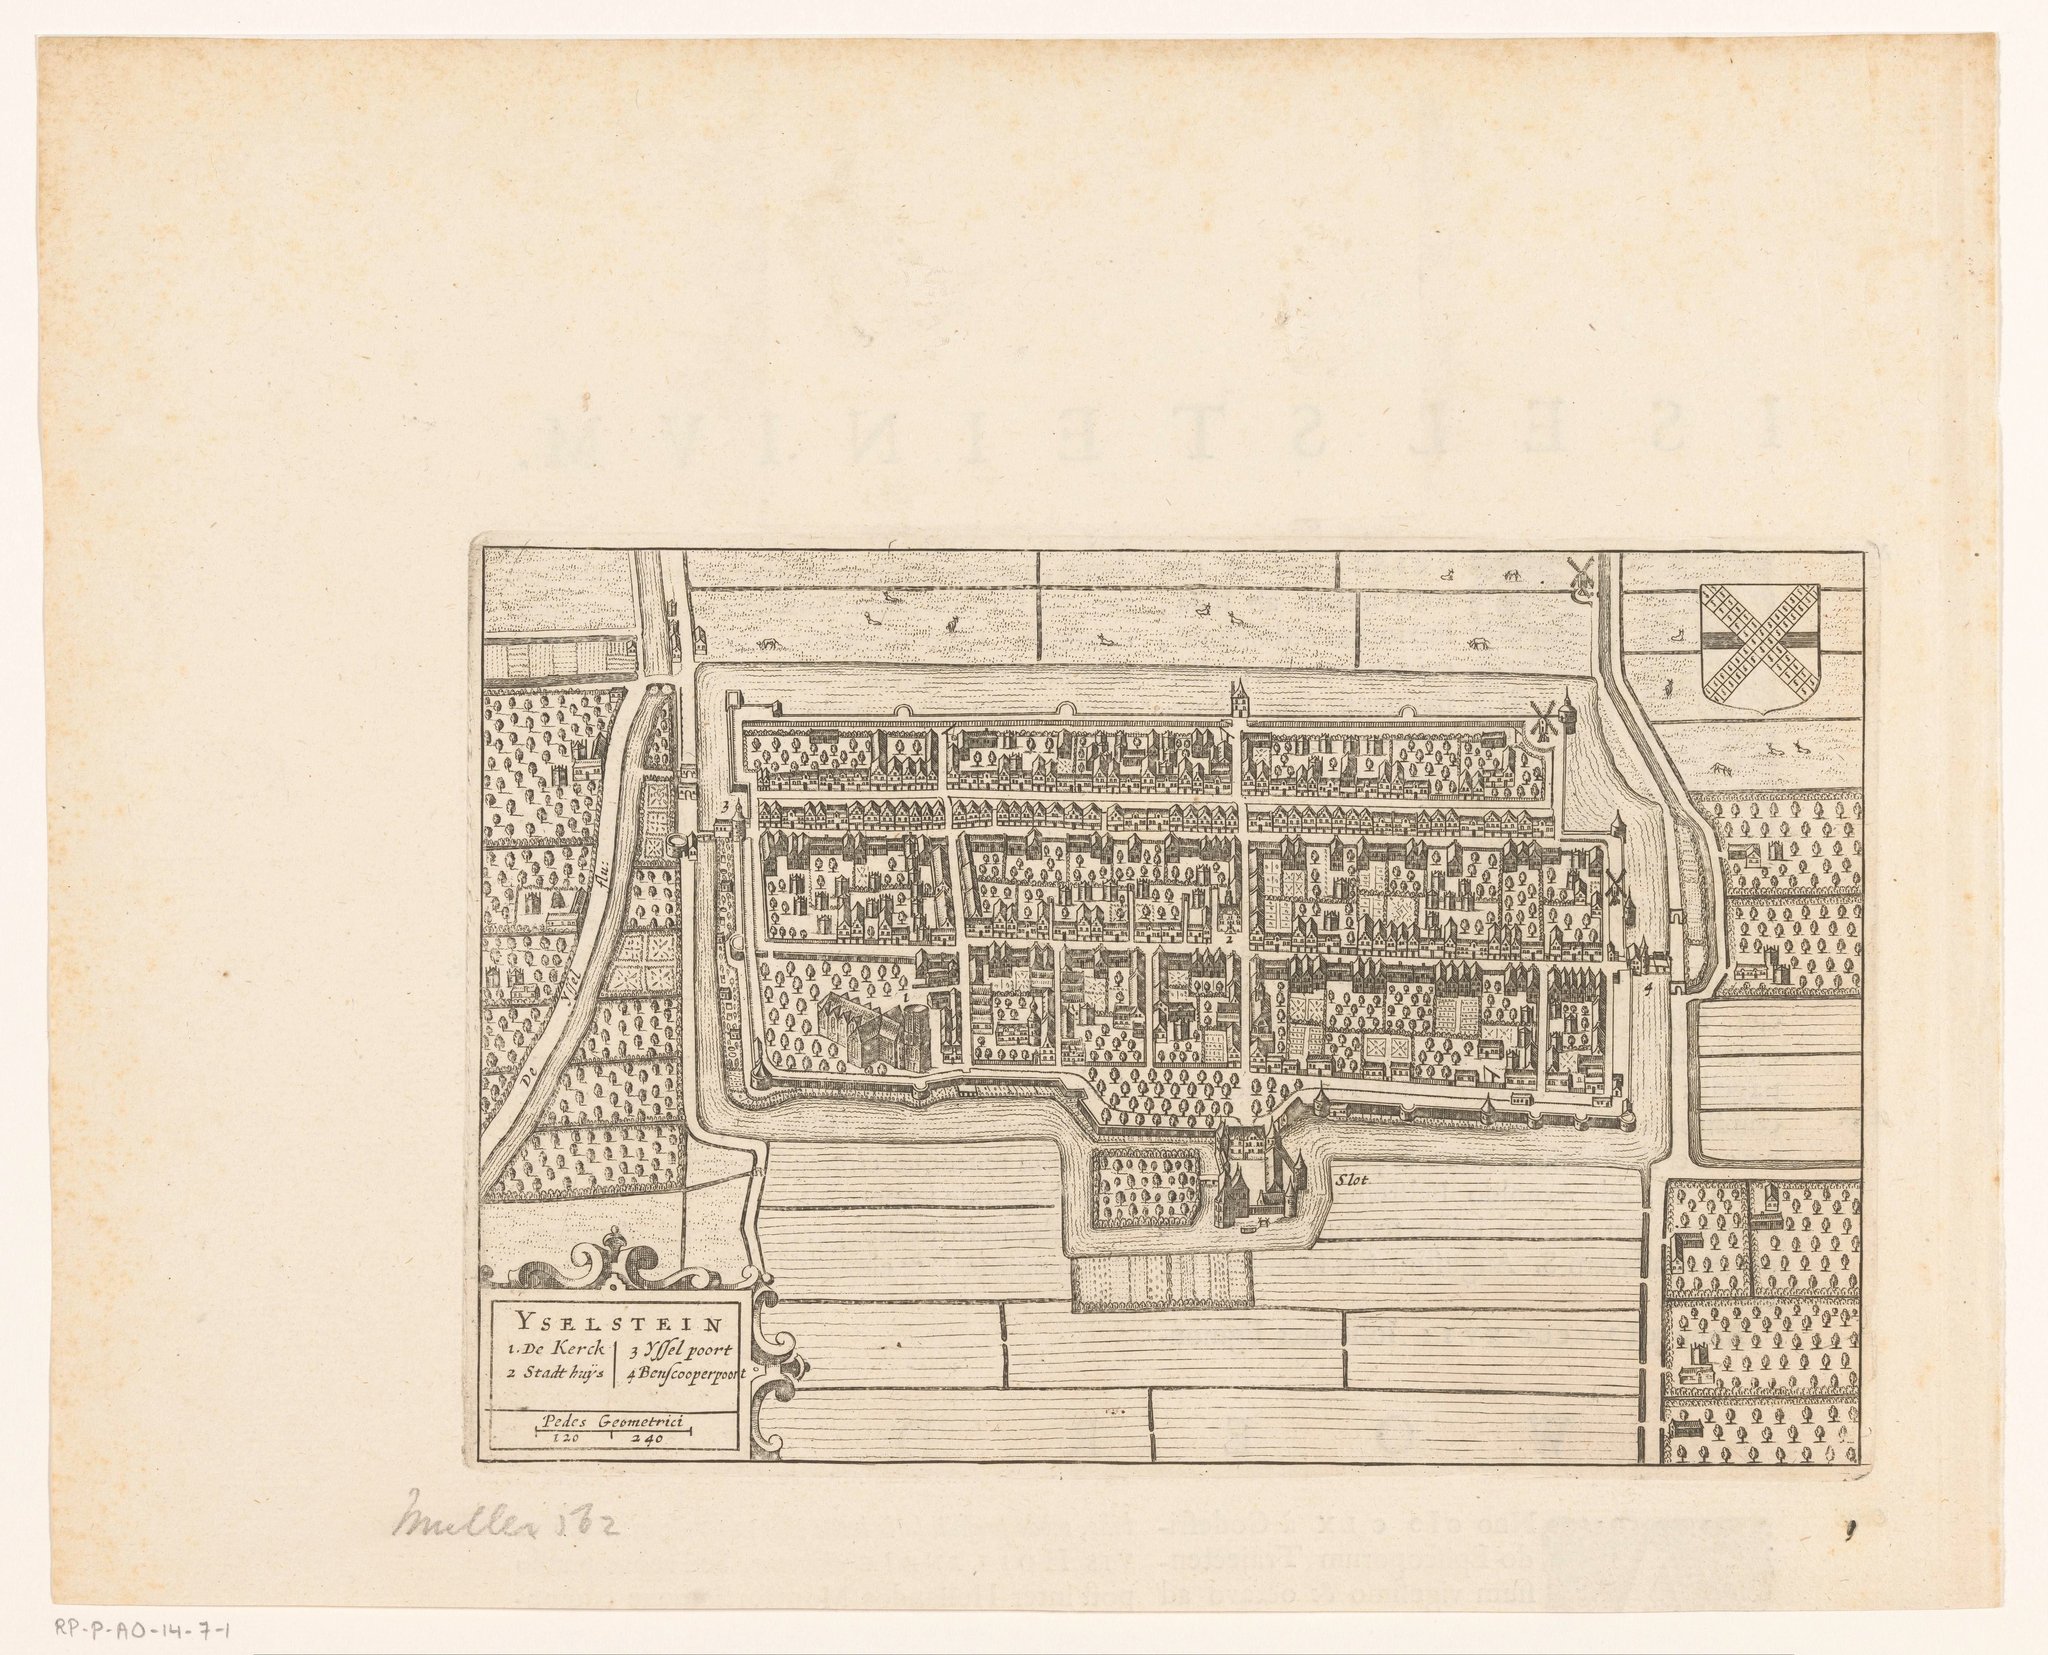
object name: area plan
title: Plattegrond van IJsselstein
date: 1632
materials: paper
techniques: engraving, etching, letterpress printing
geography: amsterdam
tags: coat of arms (as symbol of the state, etc.) (+ city; municipal), maps of cities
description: Prent gebruikt in: Blaeu, Johannes Willemszoon. Novum ac magnum theatrum urbium Belgicae (...).2 delen. 1e druk. Amsterdam: Johannes Willemszoon Blaeu, 1649, dl. 1. Of in: Blaeu, Johannes Willemszoon. Novum ac magnum theatrum urbium Belgicae (...). 2 delen. 2e druk. Amsterdam: Johannes Willemszoon Blaeu, 1649, dl. 1. Of in: Blaeu, Johannes Willemszoon. Novum ac magnum theatrum urbium Belgicae (...). 2 delen. 3e druk. Amsterdam: Johannes Willemszoon Blaeu, 1652, dl. 1. Omdat het blad is afgesneden is niet na te gaan uit welke uitgave dit exemplaar precies komt. Prent voor het eerst ook gebruikt in: Boxhorn, Marcus Zuerius van. Theatrum sive Hollandiae comitatus et urbium nova descriptio (…). Amsterdam: Henricus Hondius, 1632.